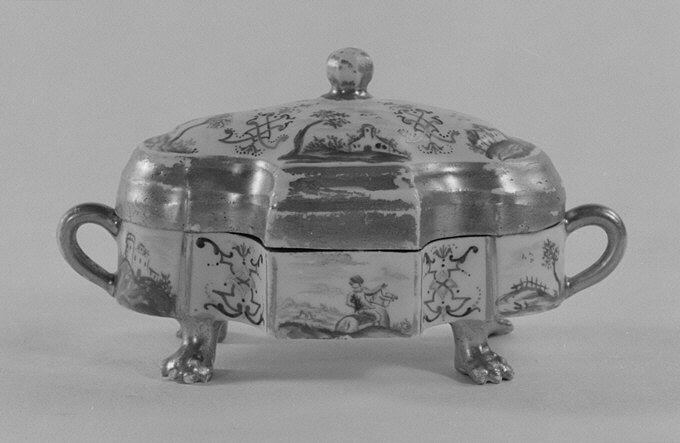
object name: sugar box with cover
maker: vienna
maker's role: manufactory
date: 1720-1725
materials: hard paste porcelain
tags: houses,horses,trees